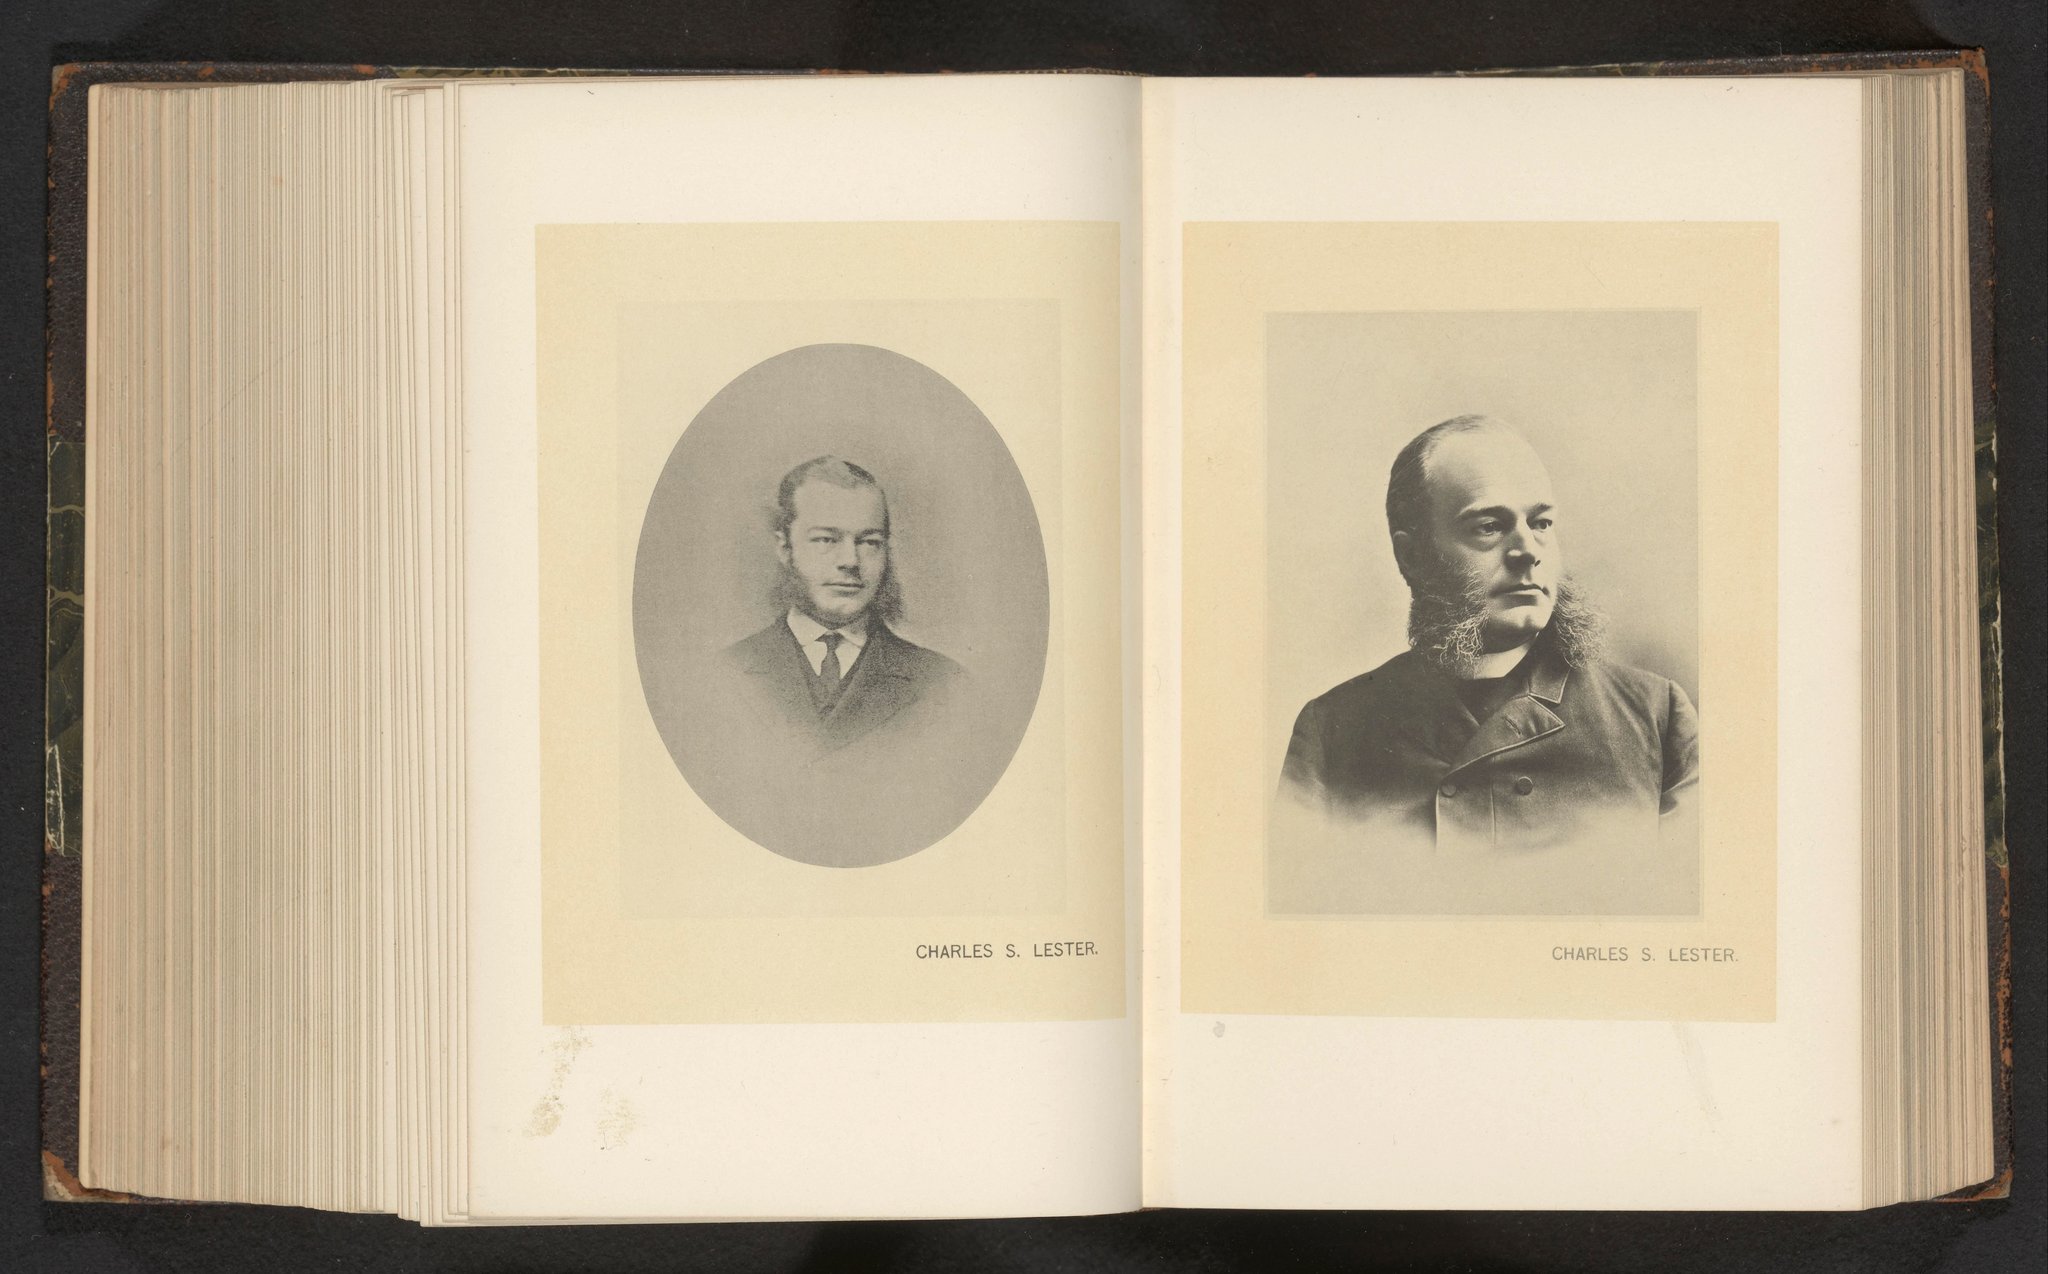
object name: page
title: Charles S. Lester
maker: Anonymous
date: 1869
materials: paper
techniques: photoaquatint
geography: boston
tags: adult man